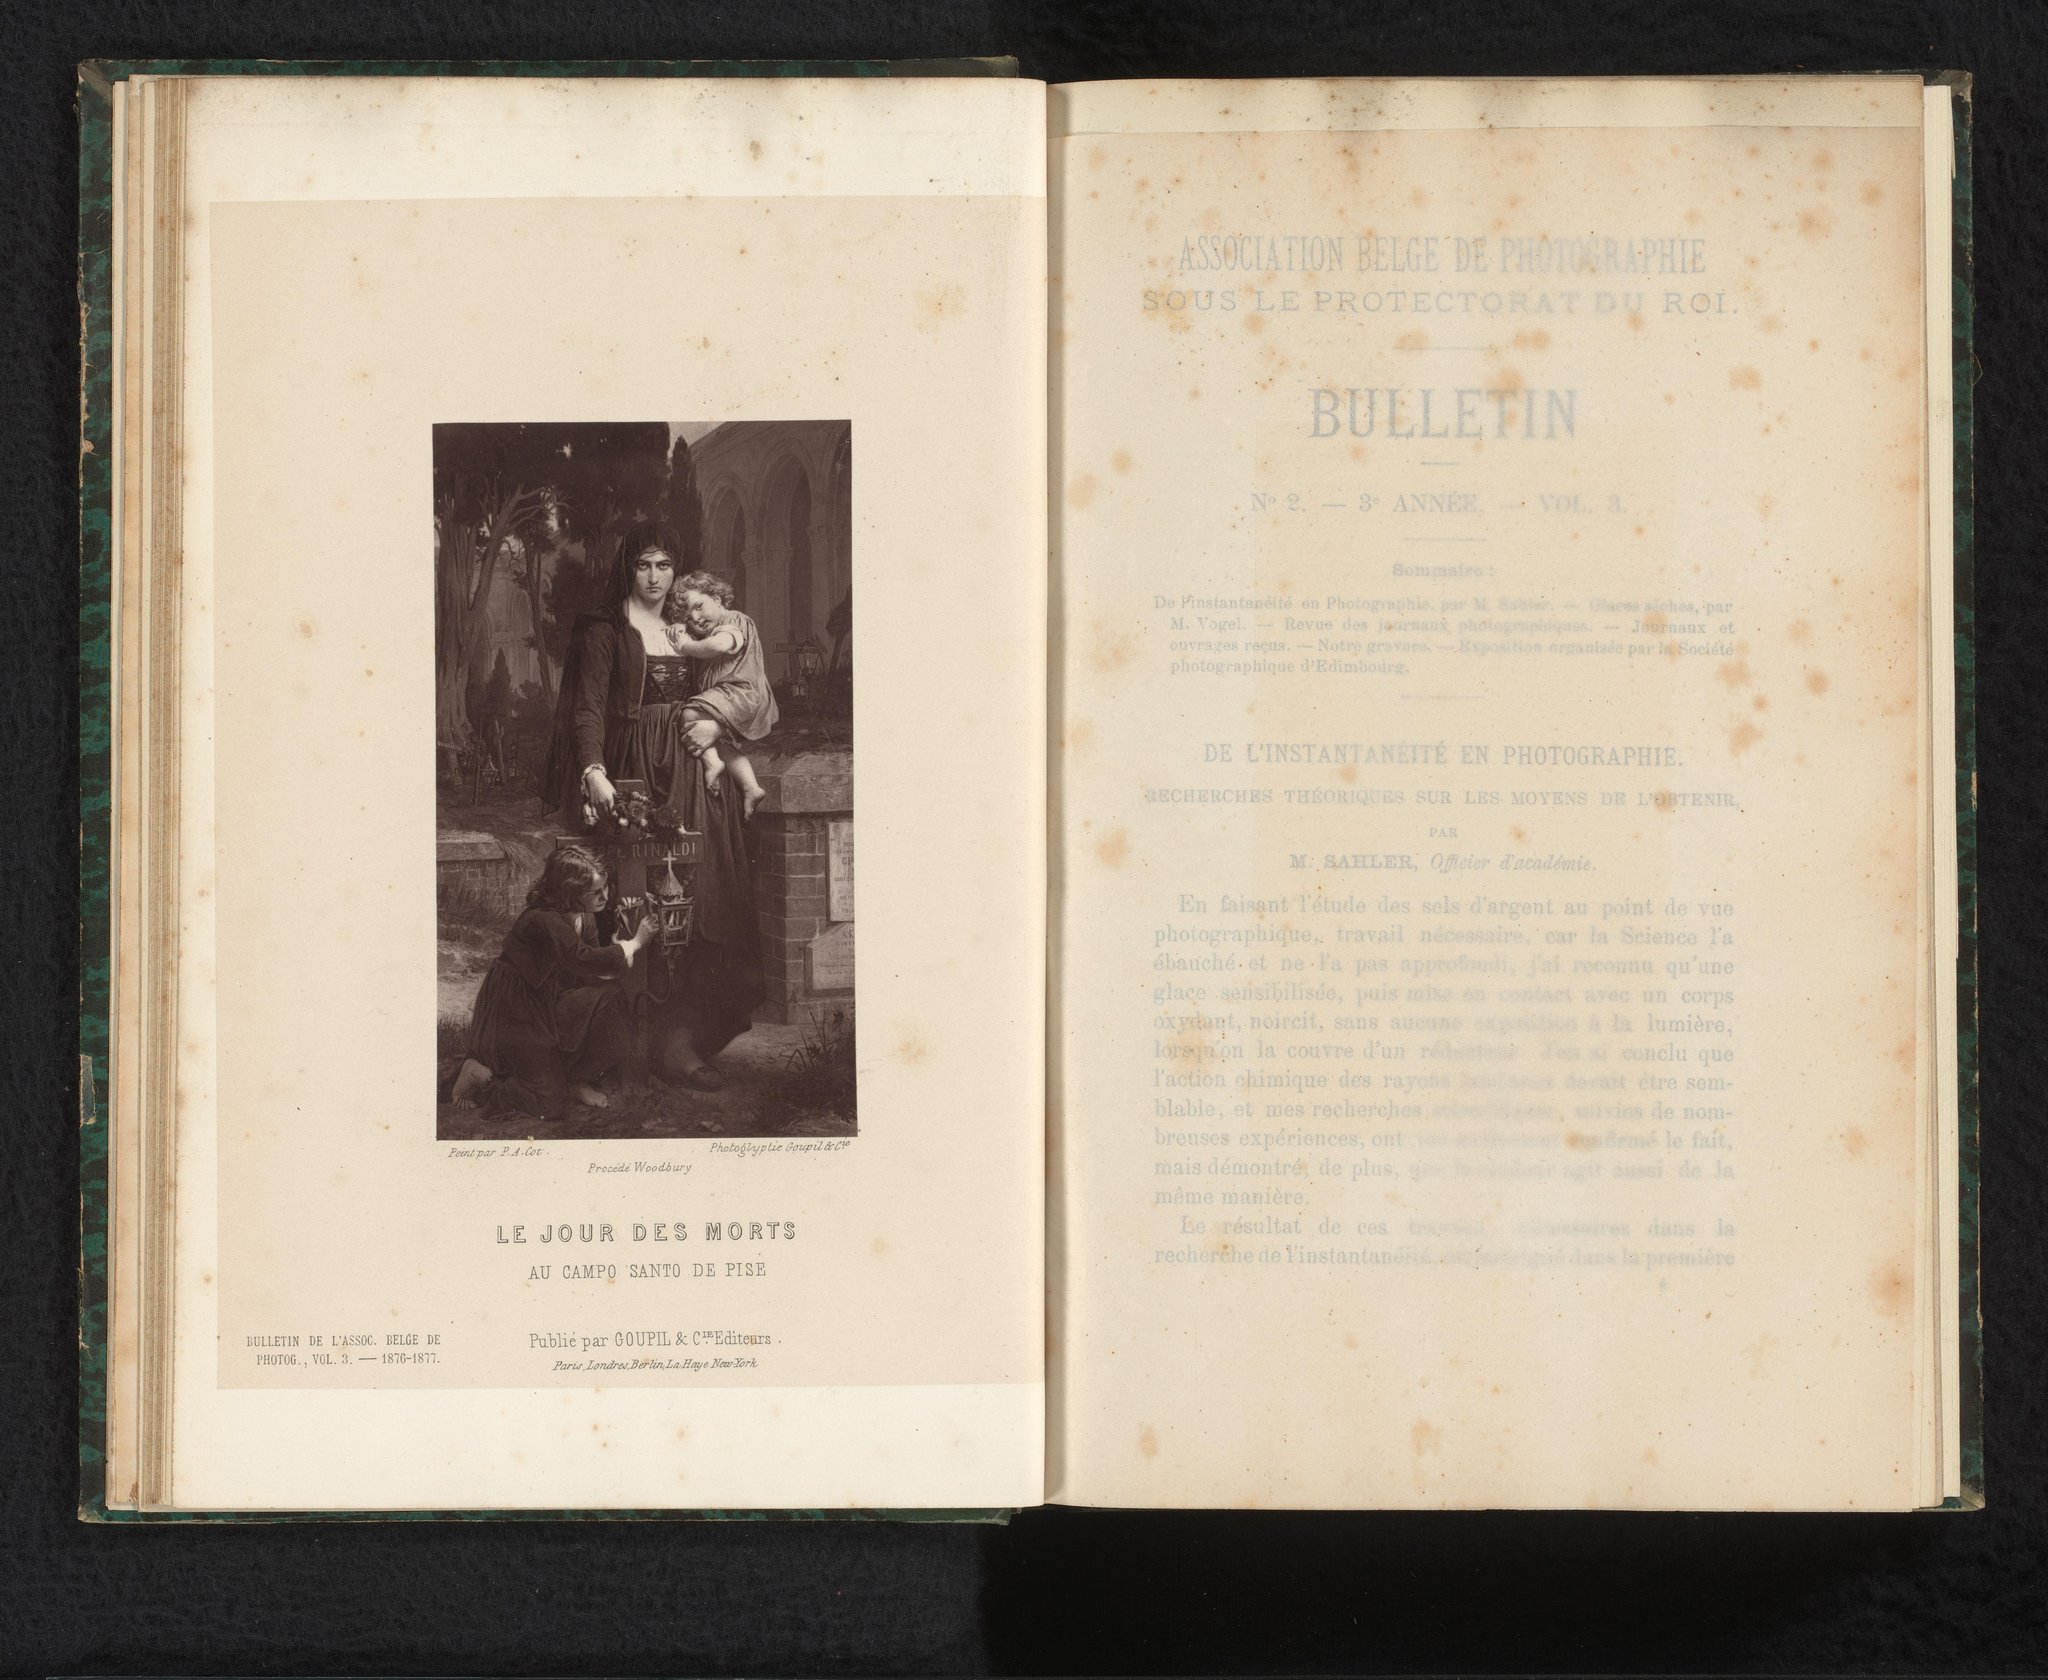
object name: photomechanical print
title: Reproductie van een schilderij van de dag van de doden in Pisa door P.A. Cot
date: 1876-1877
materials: paper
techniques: woodburytype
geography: paris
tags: all saints' day, historical persons not known by name - bb - woman, grave, tomb, mother and baby or young child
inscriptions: inscription: ‘Procédé Woodbury’